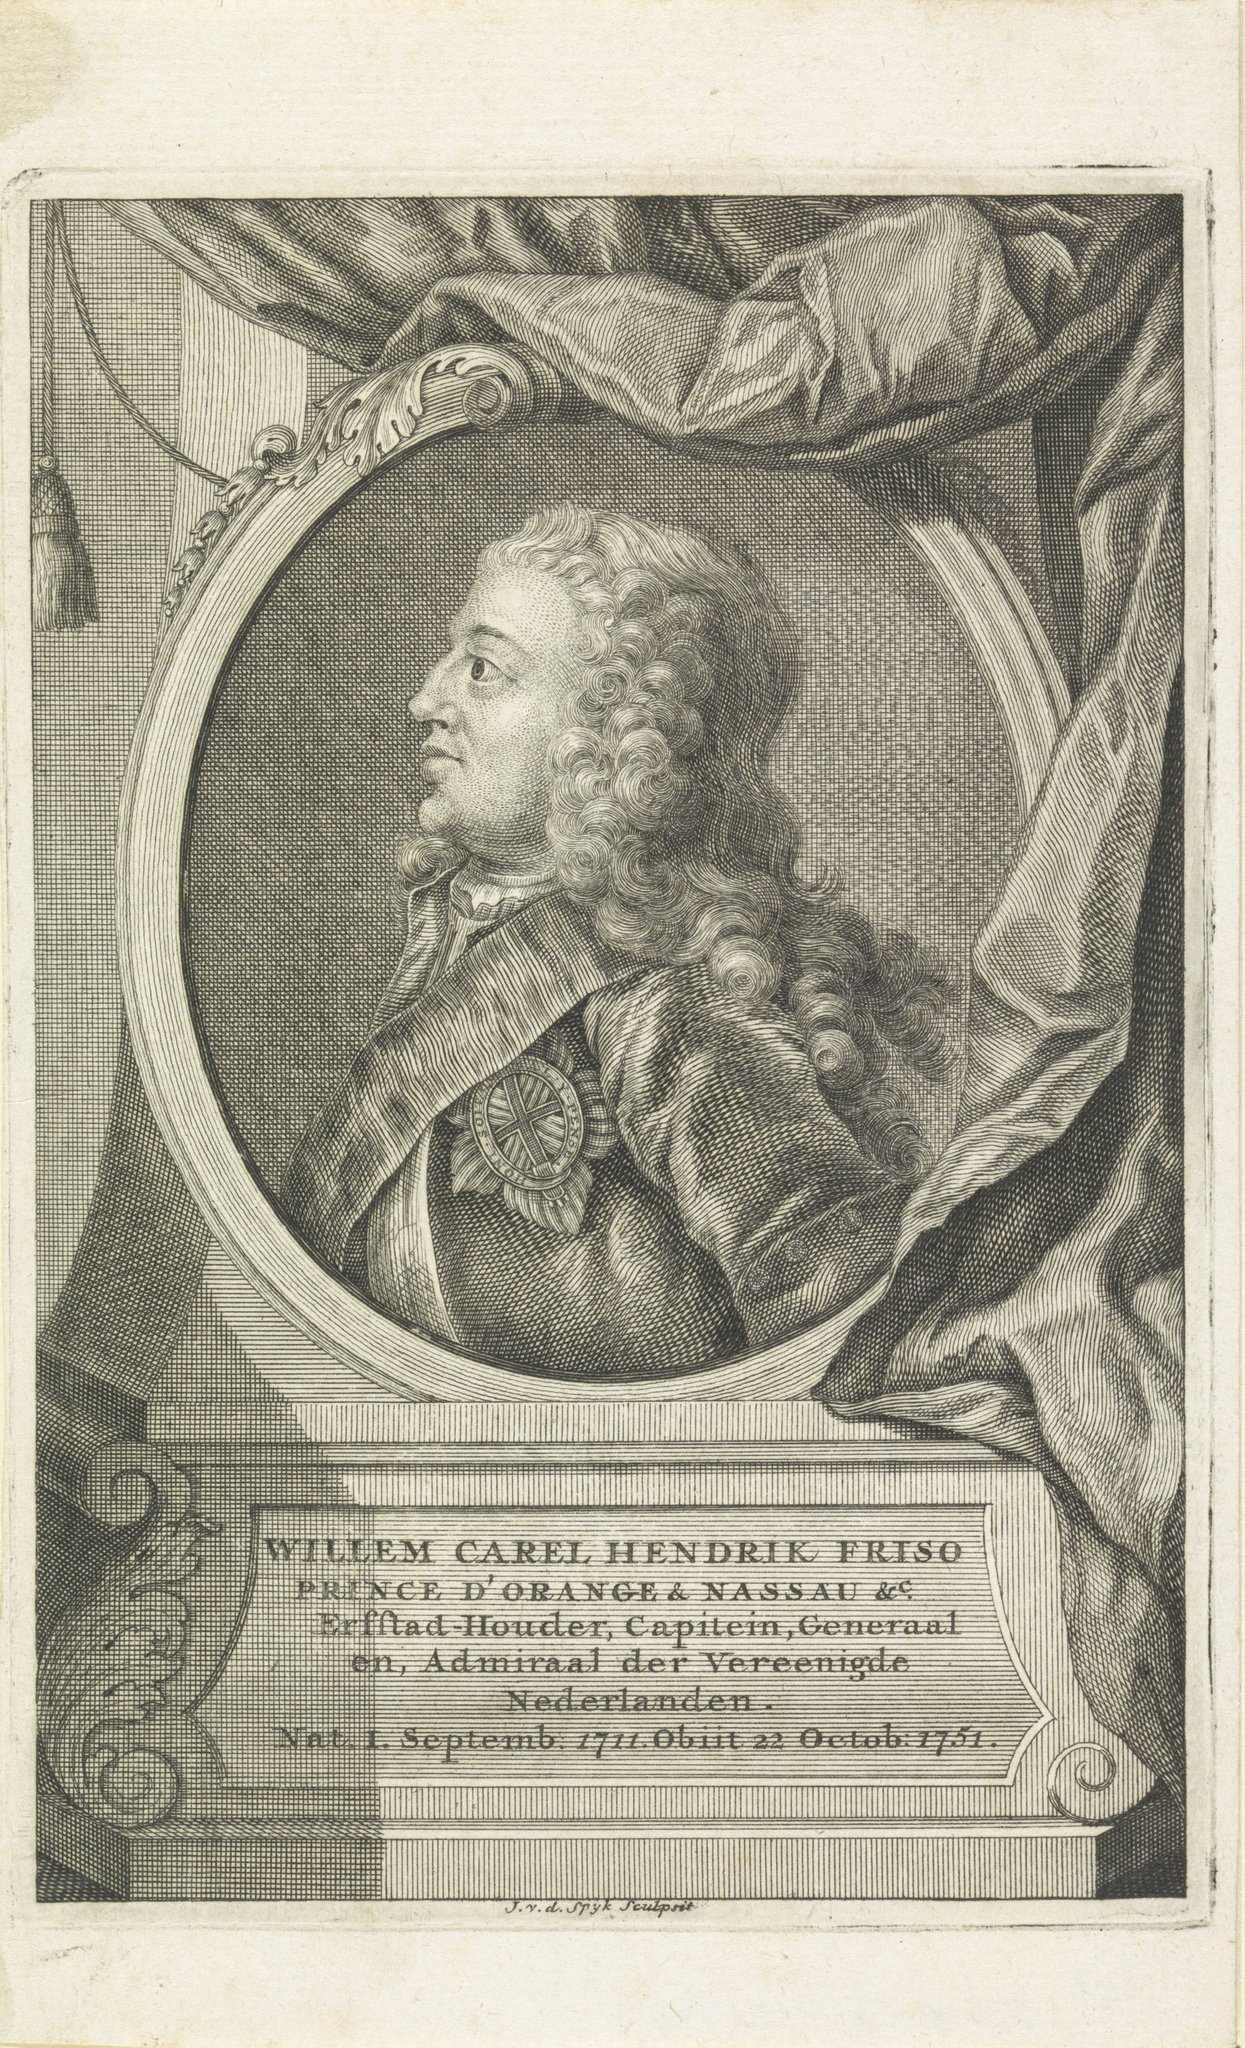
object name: print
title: Portret van Willem IV, prins van Oranje-Nassau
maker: johannes van der spyck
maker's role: print maker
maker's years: -1761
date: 1751-1761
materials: paper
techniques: engraving, etching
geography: leiden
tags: the hague, willem iv (prins van oranje-nassau), knighthood order (garter) - insignia of a knighthood order, e.g.: badge, chain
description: De hier vermelde titel verwijst naar de hoogst verkregen titel van de geportretteerde, niet per se naar de titel die de geportretteerde op deze voorstelling draagt.